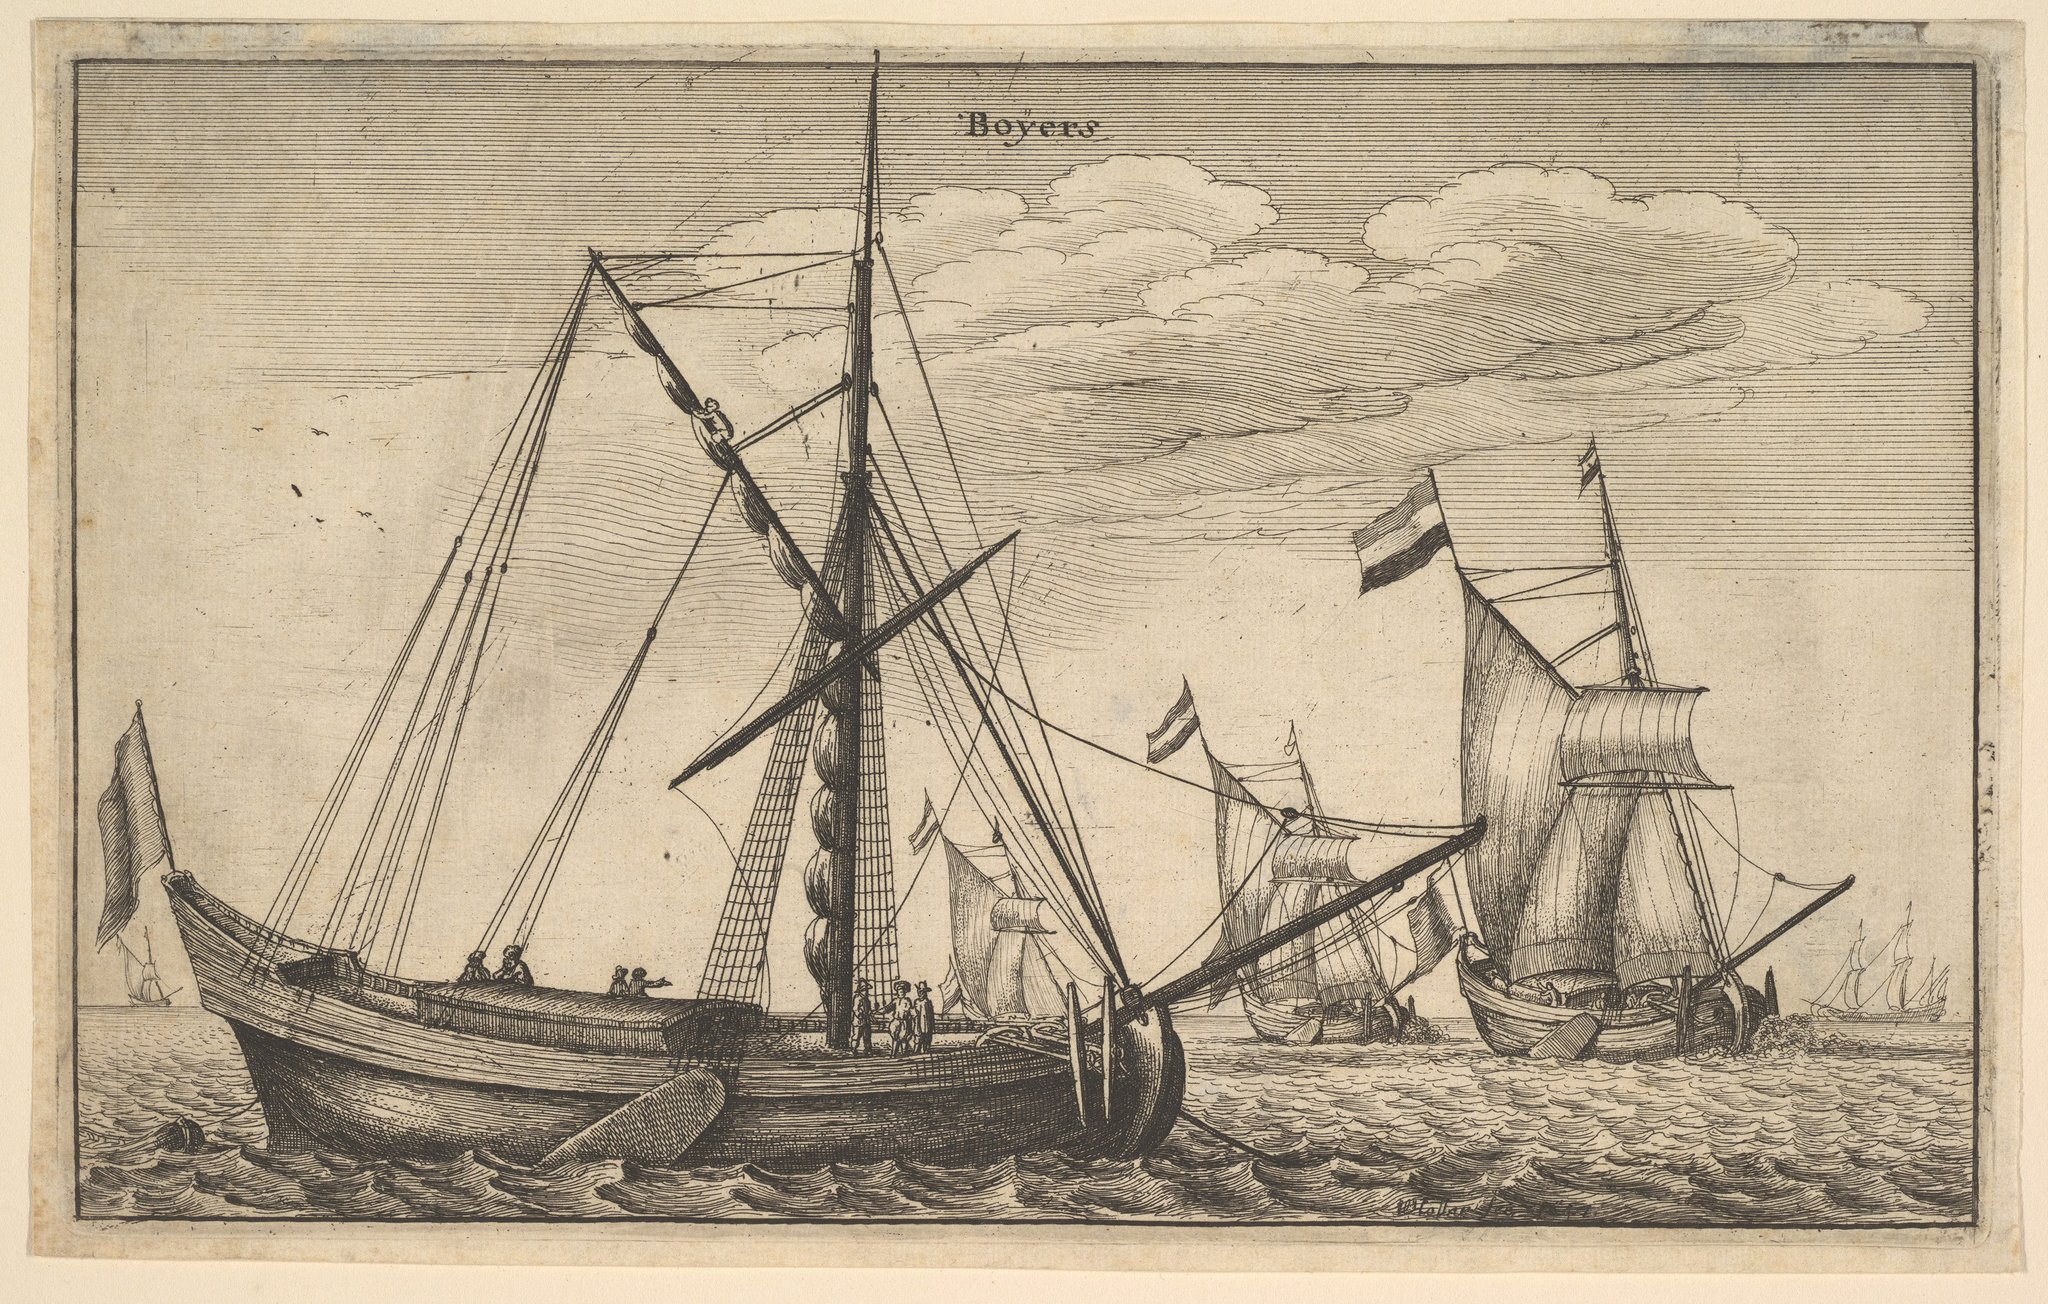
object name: print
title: Boÿers (Dutch Cargo Ship)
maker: wenceslaus hollar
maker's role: artist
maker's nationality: bohemian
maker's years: 1607-1677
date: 1647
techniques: etching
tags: ships